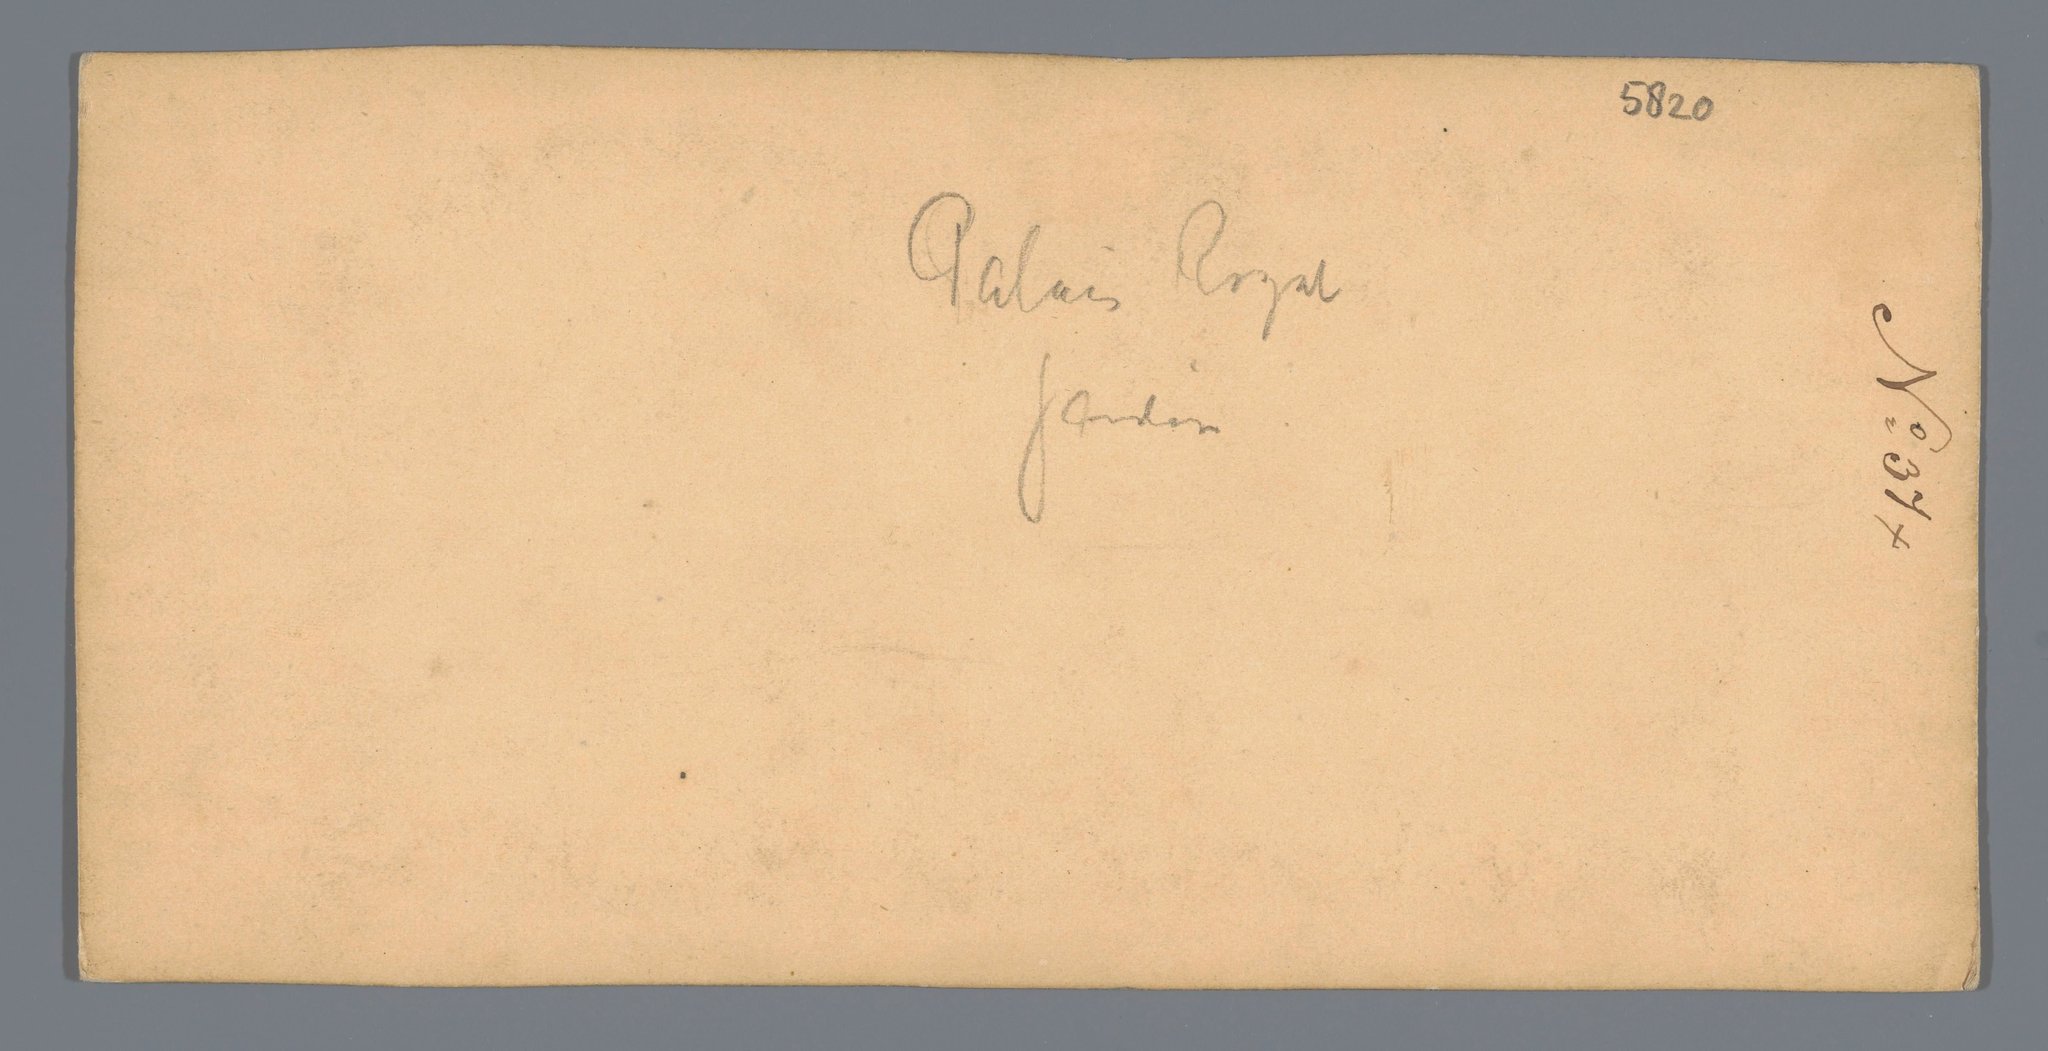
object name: stereograph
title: Gezicht op de tuin van het Palais-Royal in Parijs met een fontein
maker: Anonymous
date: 1850-1880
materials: cardboard, photographic support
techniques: albumen print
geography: paris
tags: garden, garden fountain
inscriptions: number: ‘No. 37x’, inscription: ‘Palais Royal Jardin’